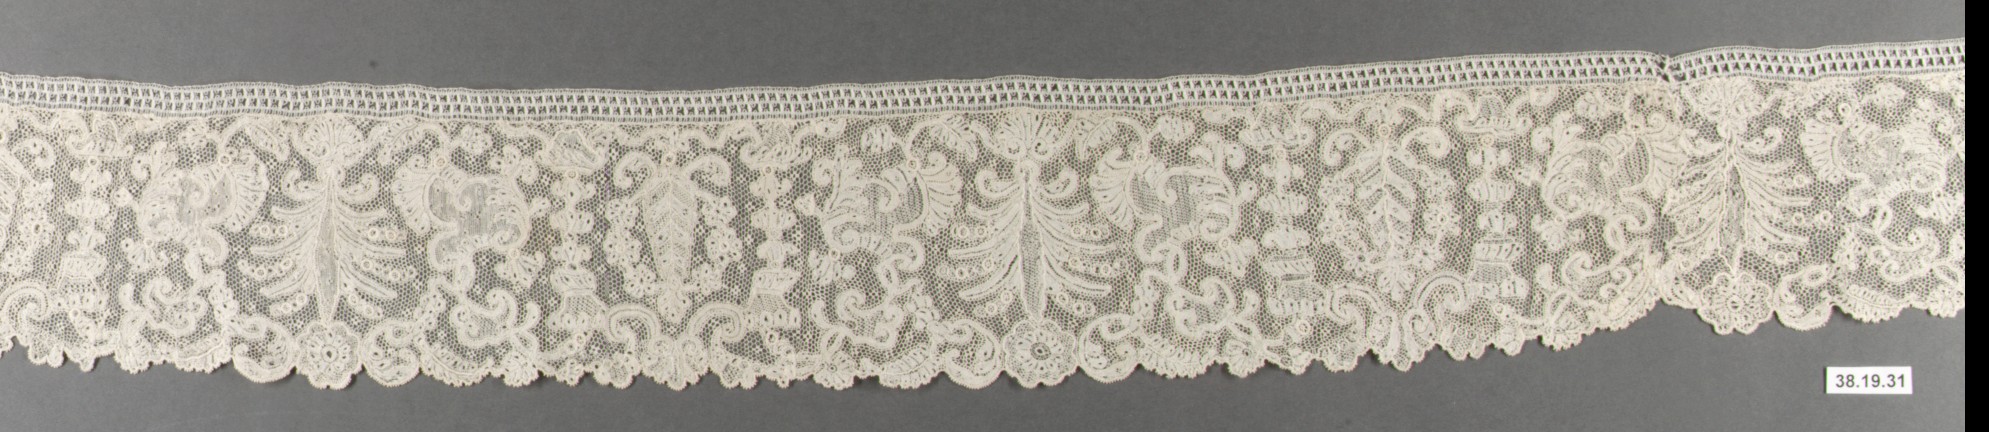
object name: border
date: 1701-1800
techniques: lace